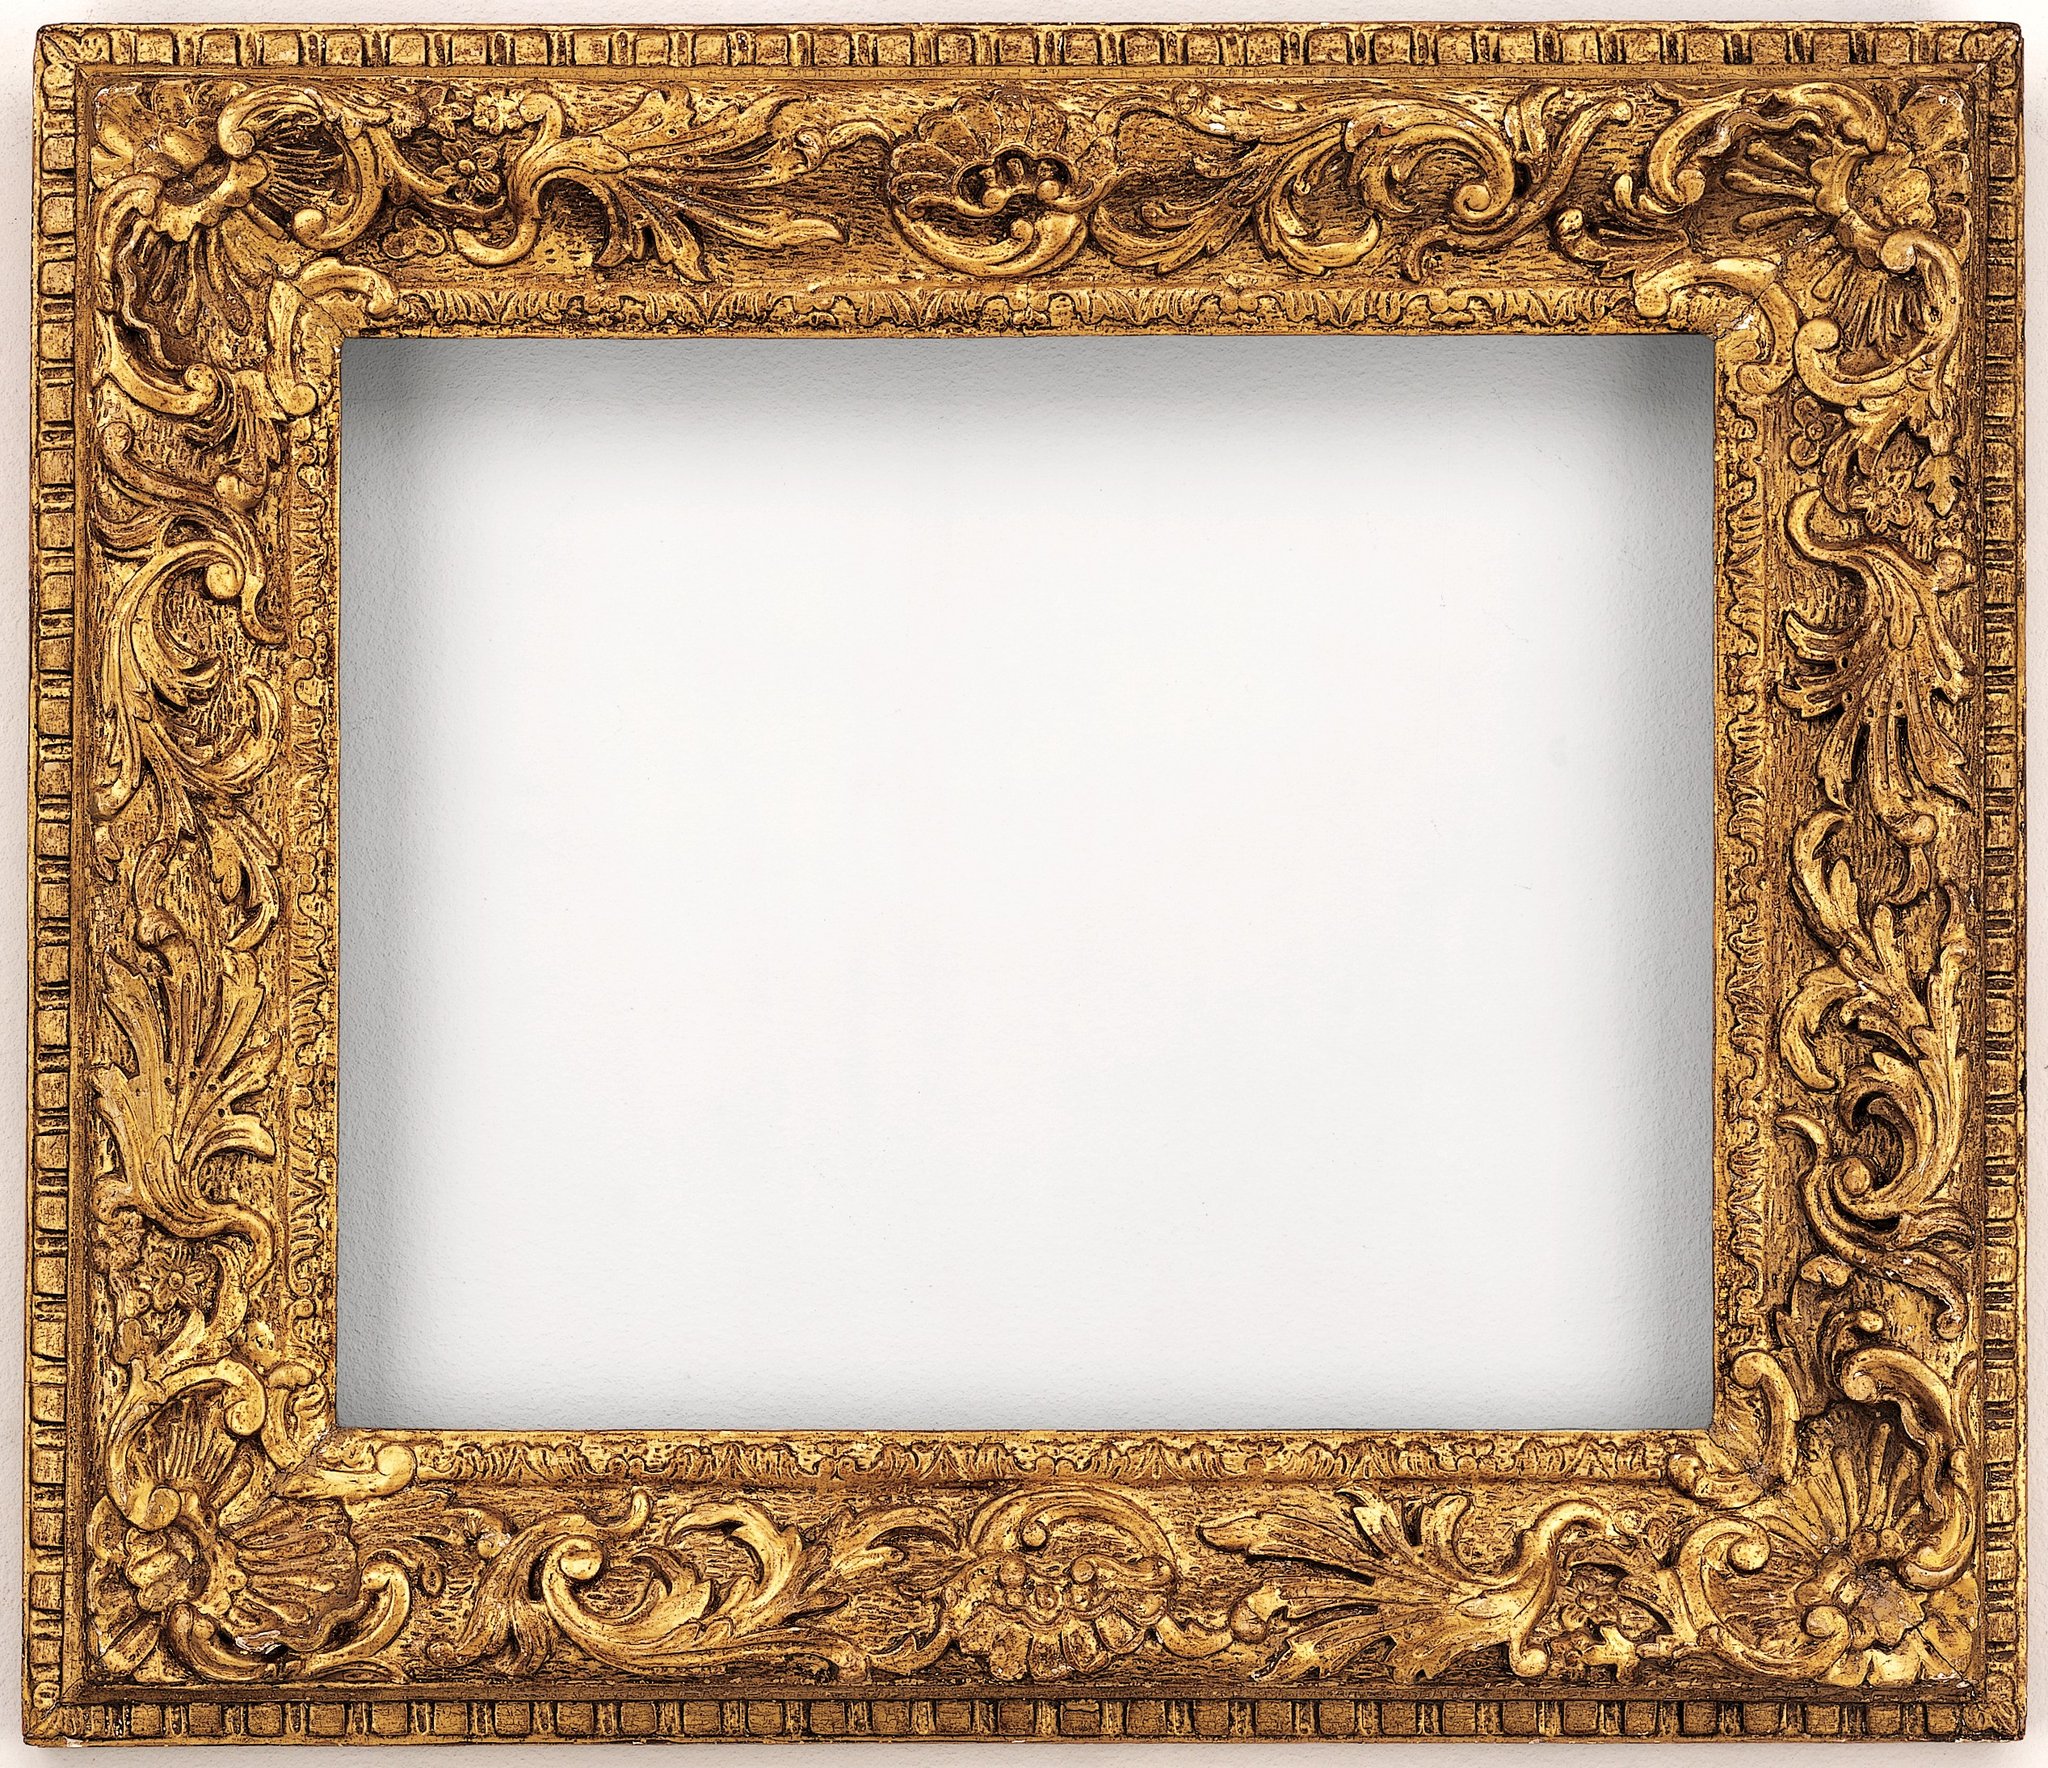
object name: frame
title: Ogee frame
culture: american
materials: wood